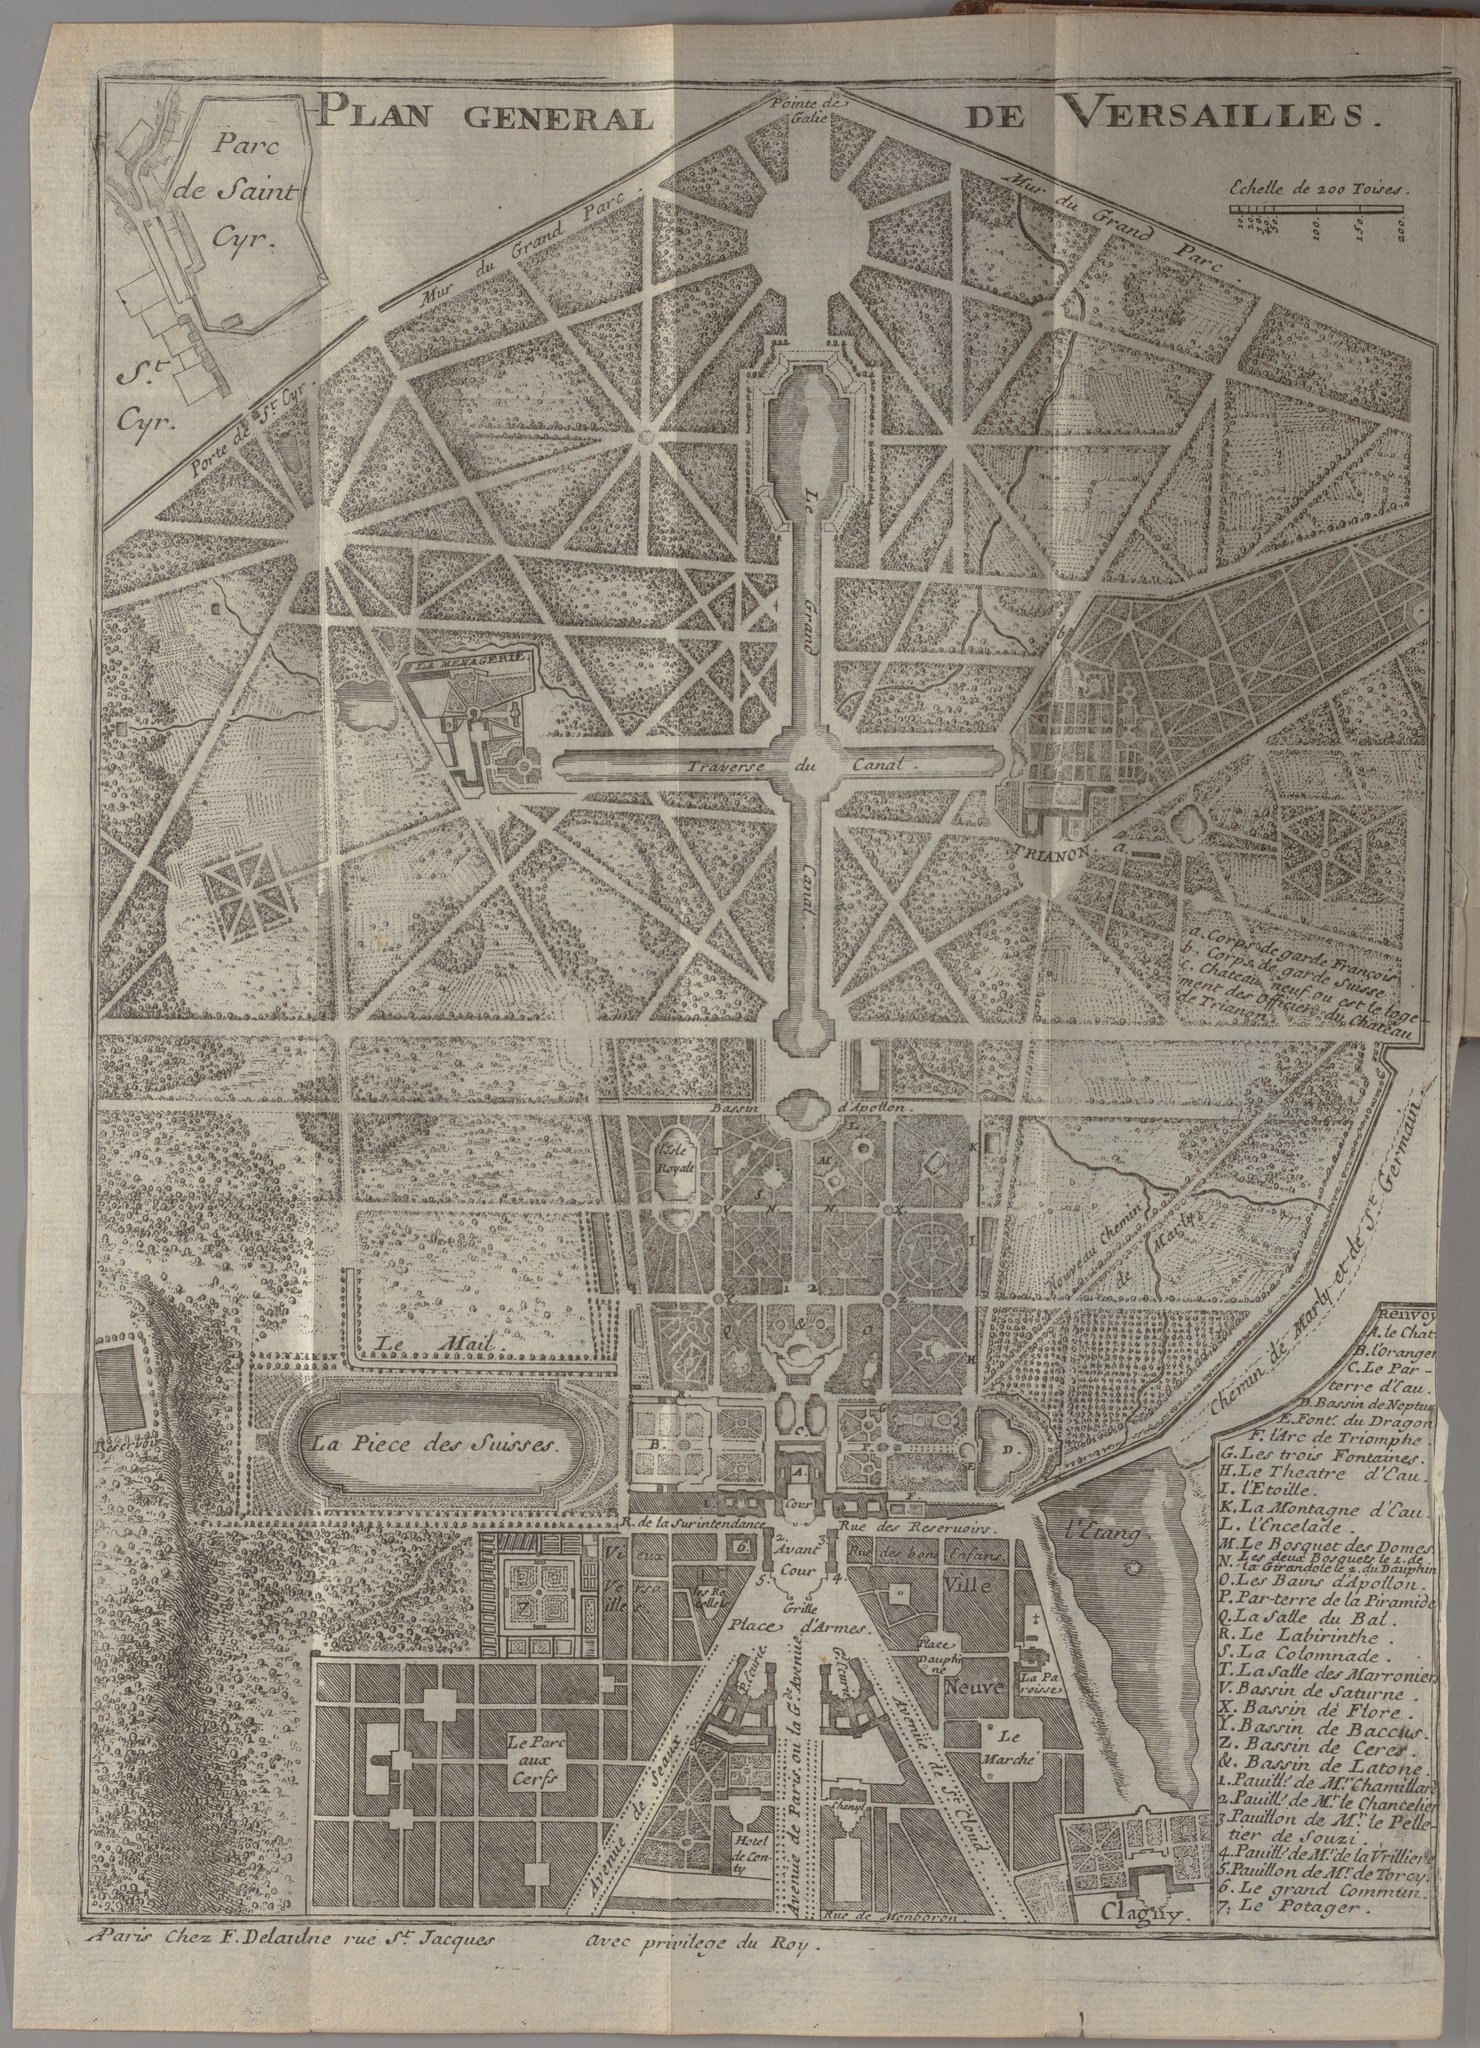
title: Nouvelle description des chateaux et parcs de Versailles et de Marly : contenant une explication historique de toutes les peintures, tableaux, statues, vases & ornemens qui s'y voient : leurs dimensions : & les noms des peintres, des sculpteurs & des graveurs qui les ont faits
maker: jean-aimar piganiol de la force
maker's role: author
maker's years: 1673-1753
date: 1724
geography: france